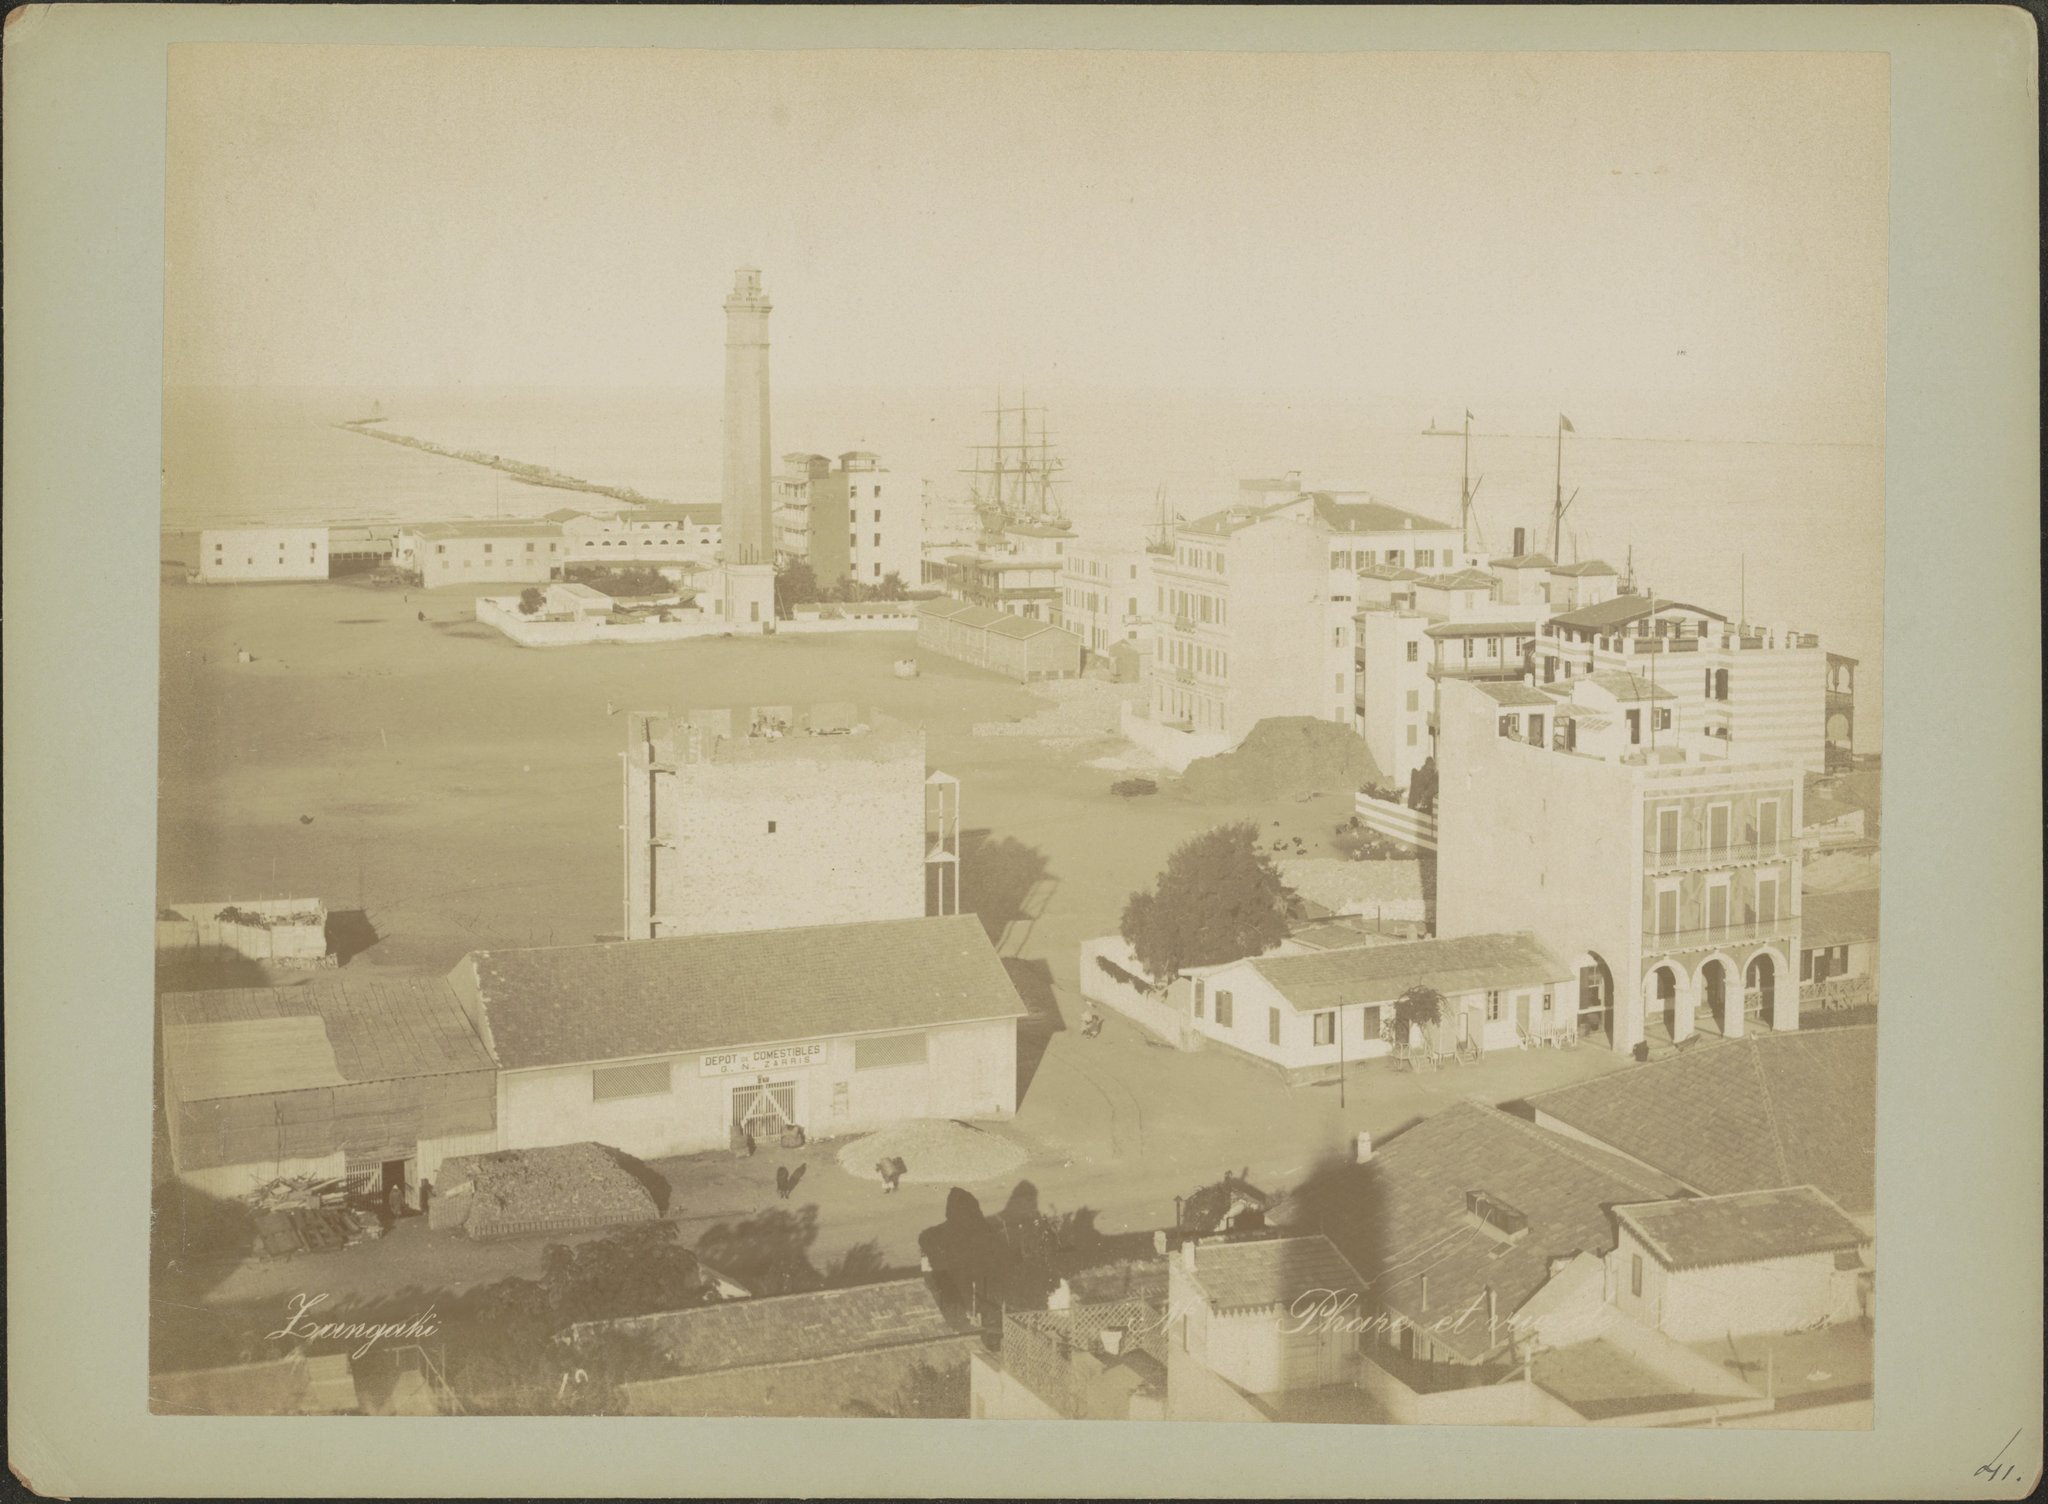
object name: album leaf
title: Phare et vue de Port Said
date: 1870-1890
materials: cardboard, paper, photographic support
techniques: albumen print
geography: port said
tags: canal, prospect of city, town panorama, silhouette of city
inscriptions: inscription: ‘Port. Said’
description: Onderdeel van Reisalbum met foto's van bezienswaardigheden in Marseille, Port Said, Aden, Bombay, Colombo, Singapore en Nederlands-Indië.